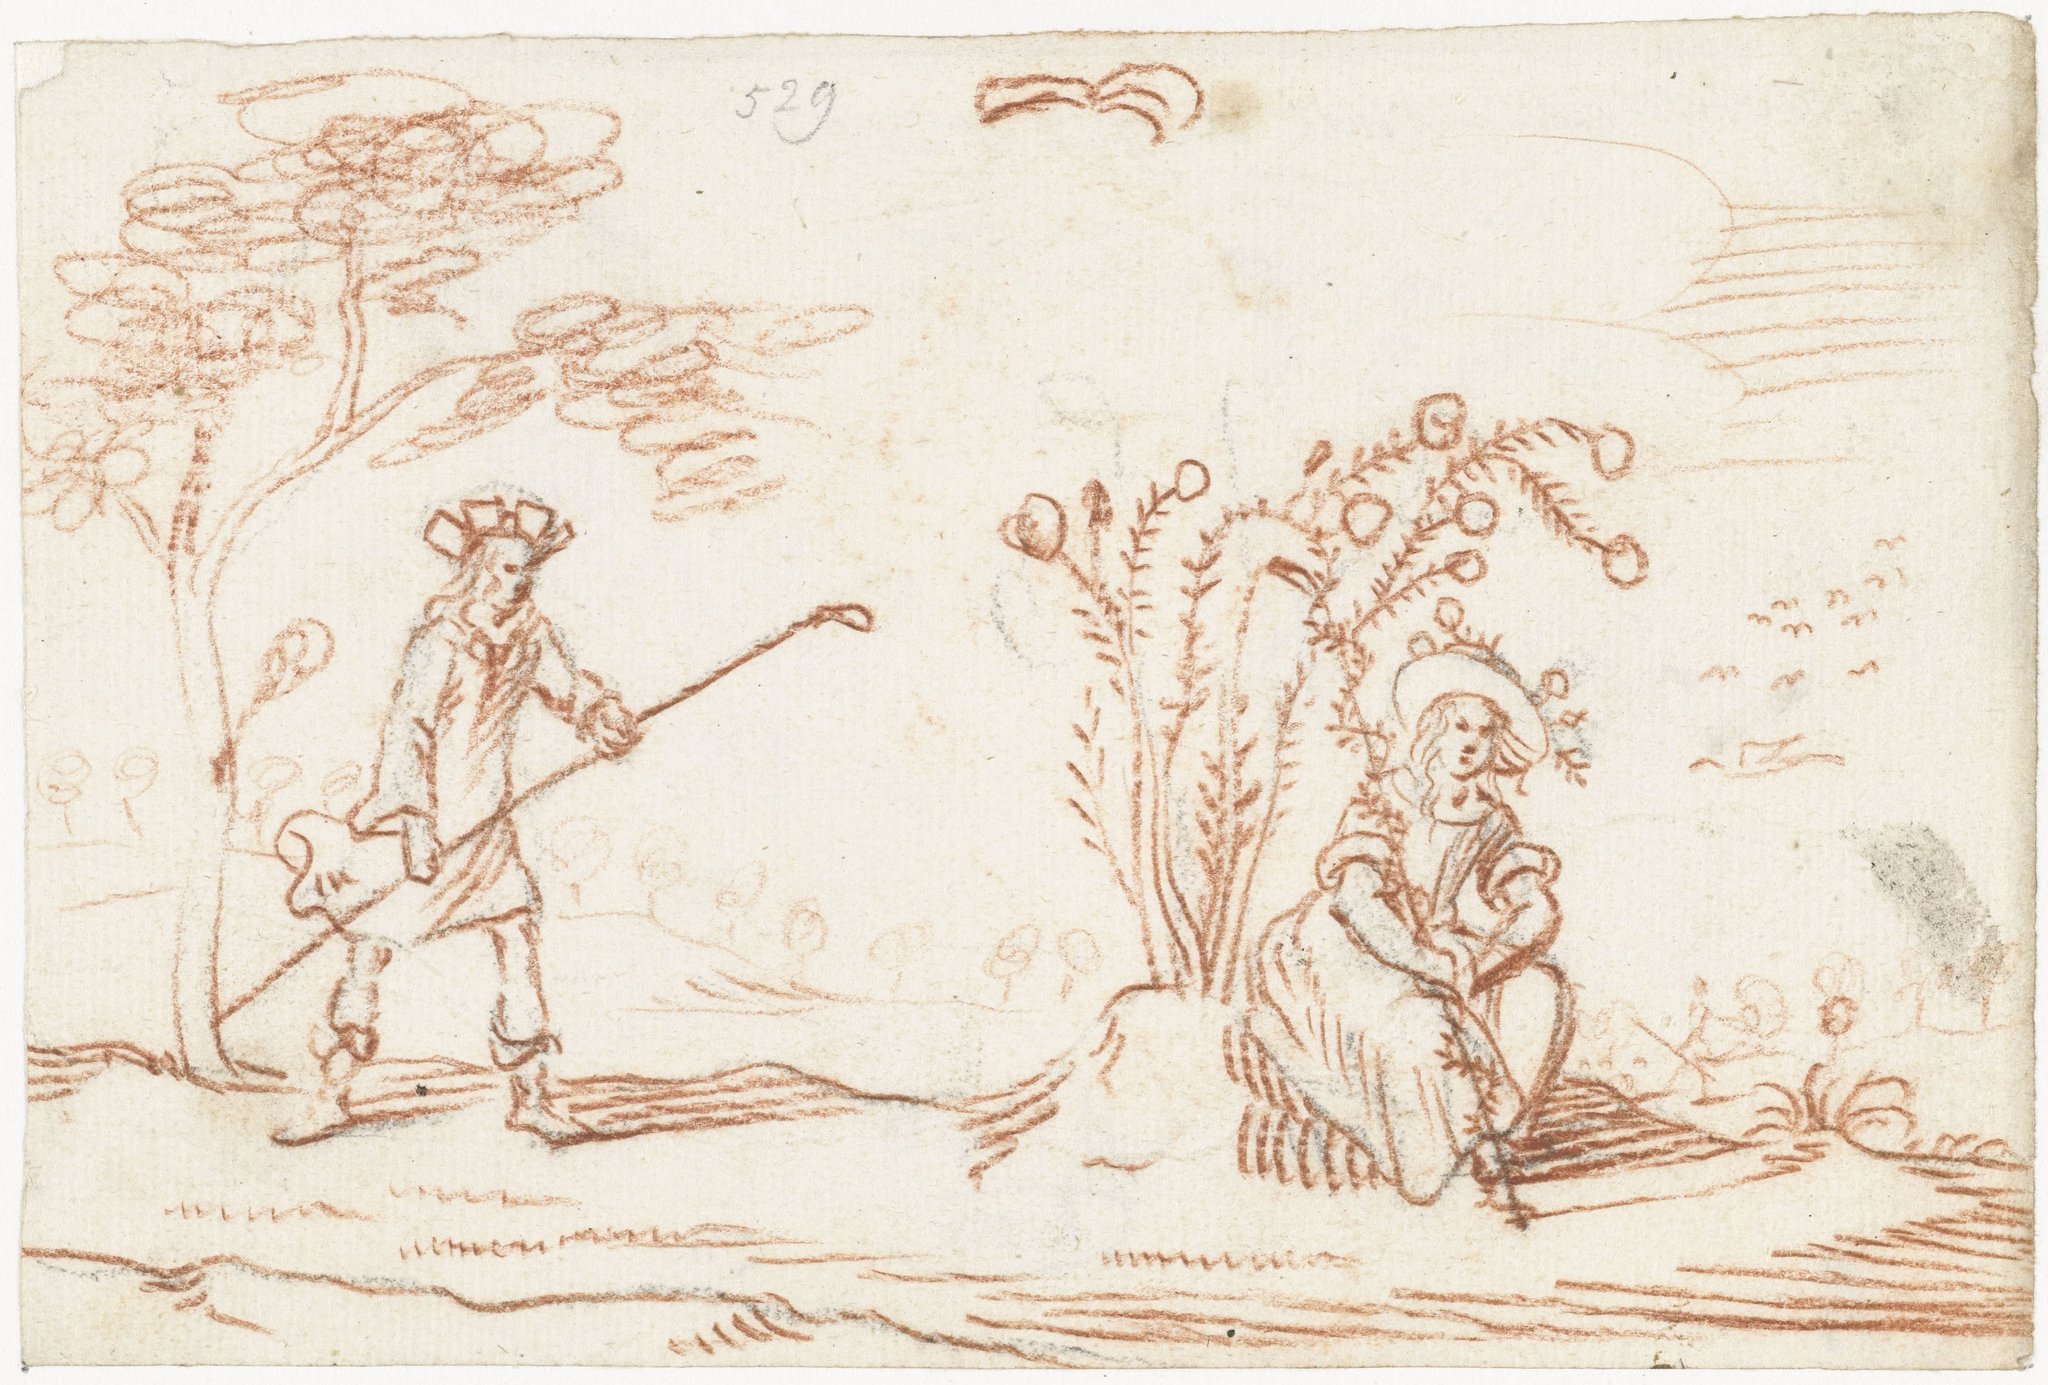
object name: drawing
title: Pastorale scène met twee figuren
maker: gesina ter borch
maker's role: draughtsman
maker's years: 1633-1690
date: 1652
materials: chalk, paper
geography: zwolle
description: Voorstudie voor de illustratie op folio 10 van het Poëzie-album.